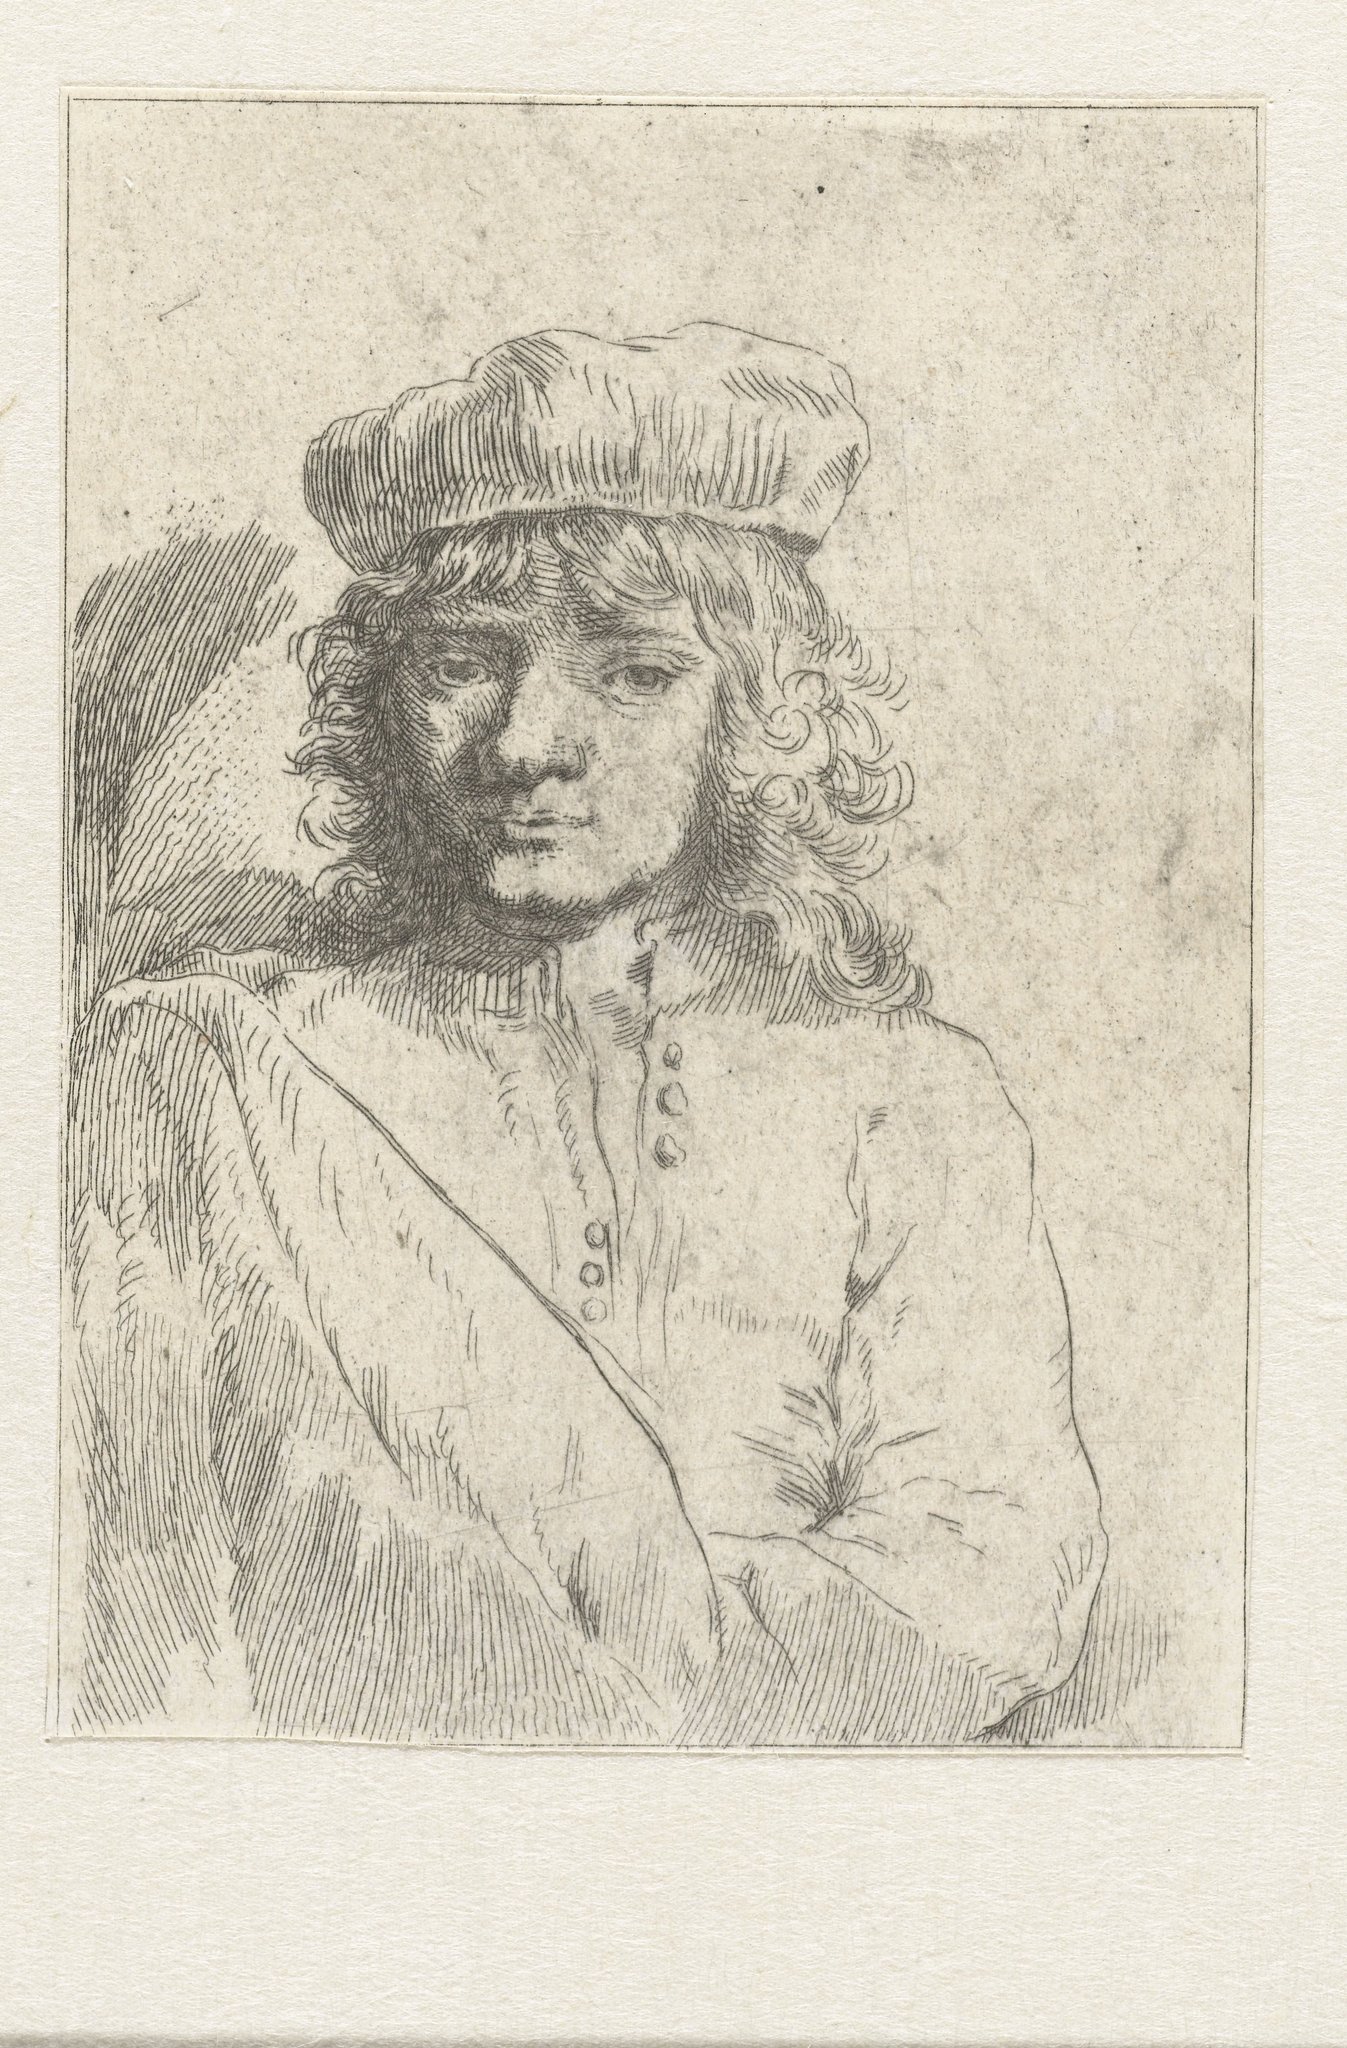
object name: print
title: The artist's son, Titus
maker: pierre françois basan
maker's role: print maker, publisher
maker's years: 1723-1797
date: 1819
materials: paper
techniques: etching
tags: draughtsman, historical persons, male infant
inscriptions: collector's mark: Lugt 2760, collector's mark: Lugt 2228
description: Prent voor het eerst gebruikt in: Recueil de Quatre-Vingt-Cinq estampes originales, têtes, paysages et différens sujets, dessinées et gravées par Rembrandt. Parijs: Henry Louis Basan, 1819.